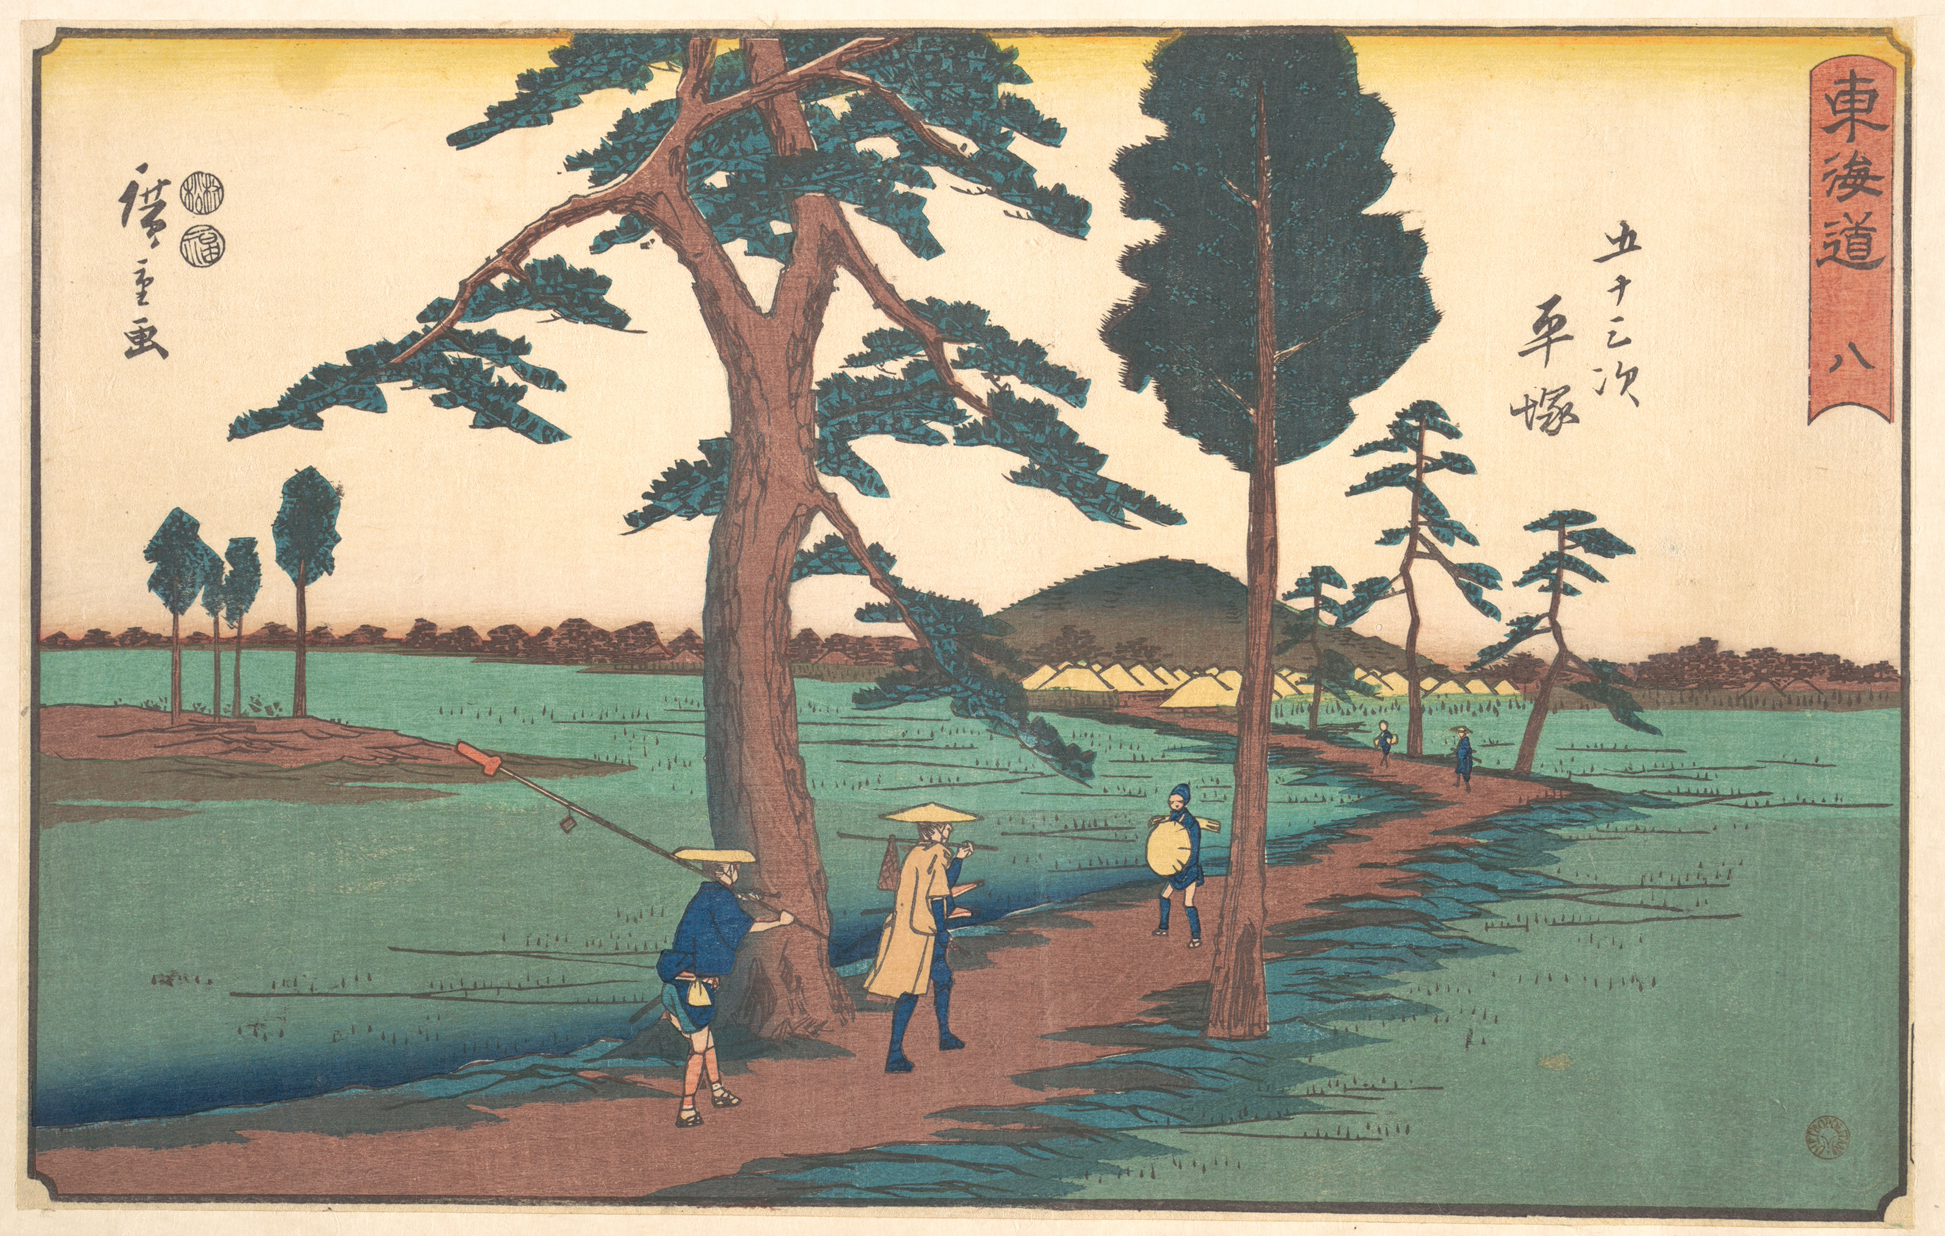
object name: print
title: Hiratsuka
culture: japanese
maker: utagawa hiroshige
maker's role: artist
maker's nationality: japanese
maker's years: 1797-1858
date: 1840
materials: ink, paper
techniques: woodblock print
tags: human figures,landscapes,trees